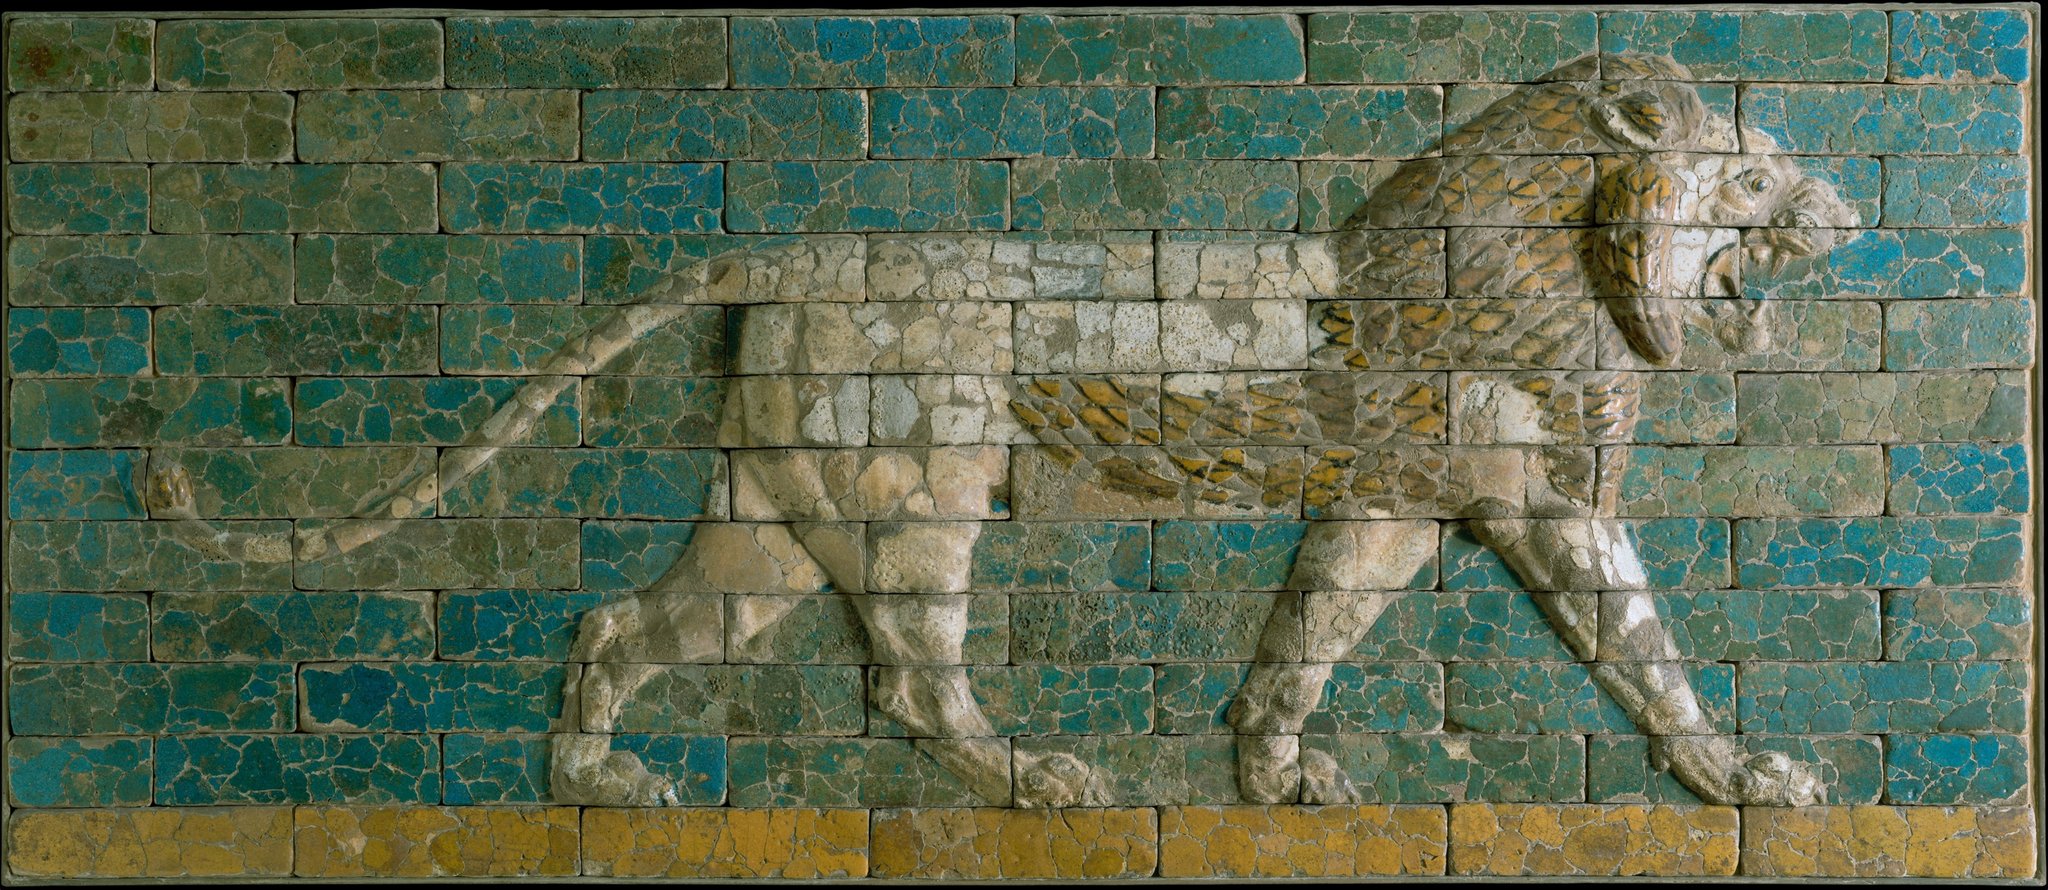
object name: relief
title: Panel with striding lion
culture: babylonian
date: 604-562 BCE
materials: ceramic, glaze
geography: mesopotamia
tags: lions